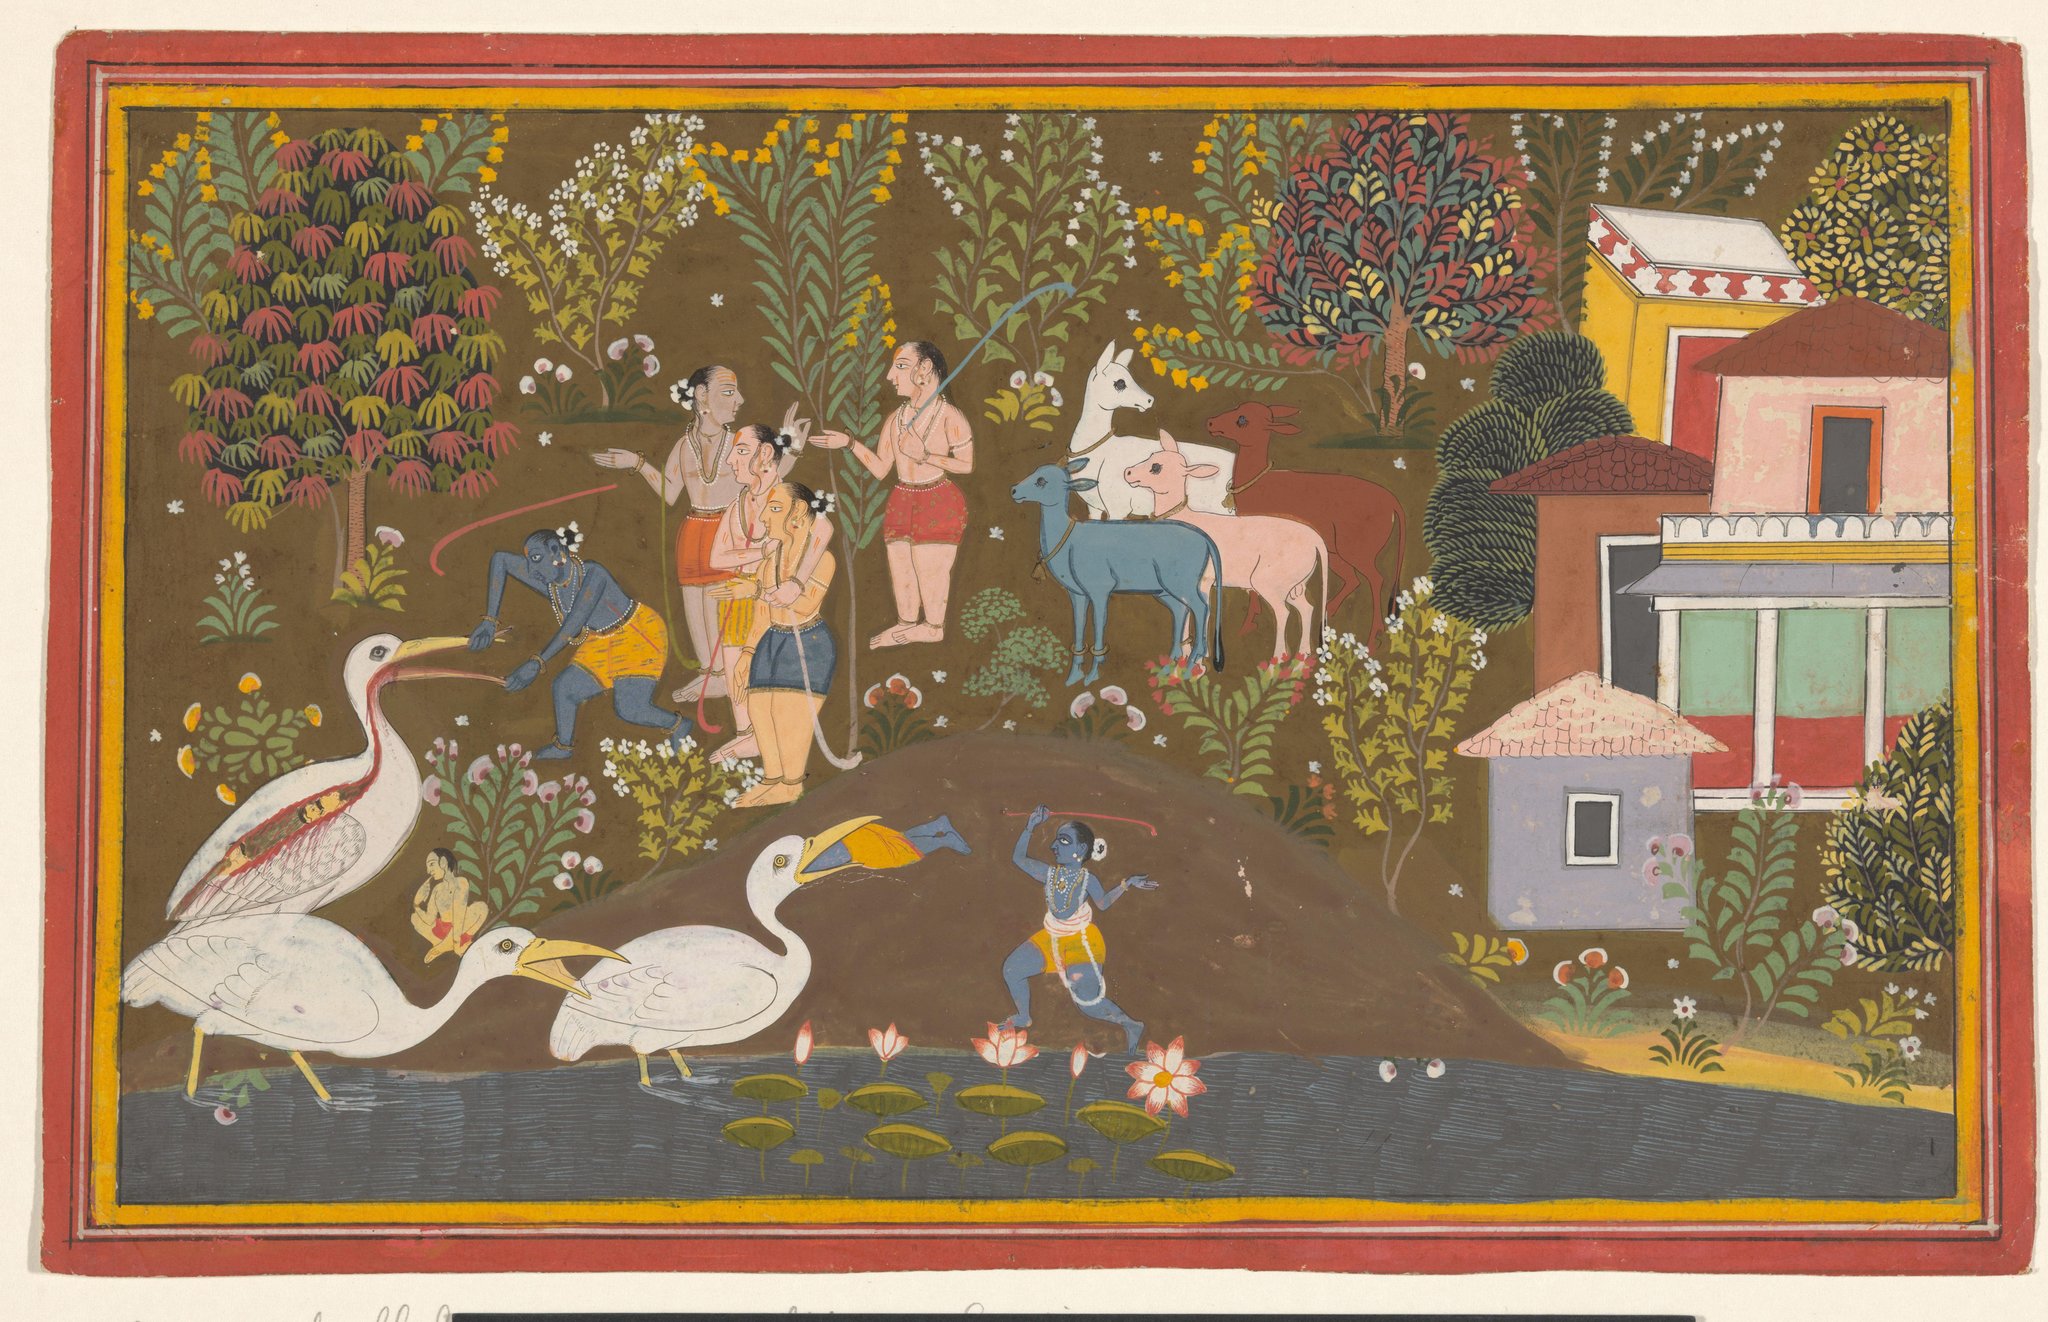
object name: drawing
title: Krishna met Bakasura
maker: Anonymous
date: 1710-1730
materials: paper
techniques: brush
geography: rajasthan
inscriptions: inscription